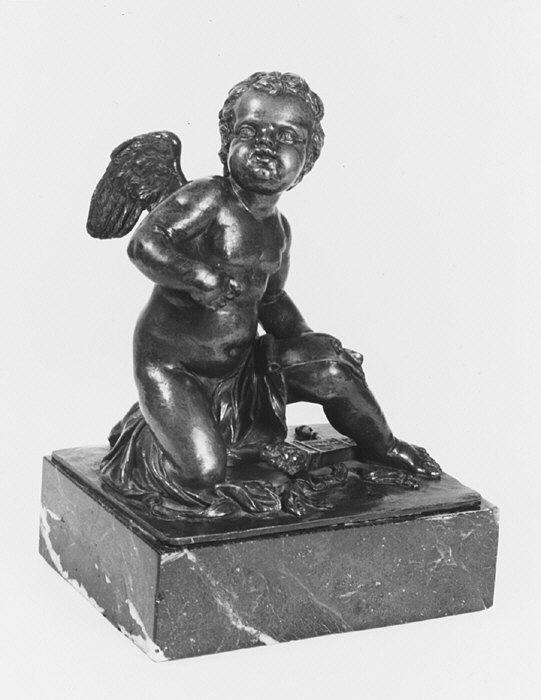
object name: statuette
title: Cupid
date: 1701-1800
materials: bronze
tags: cupid